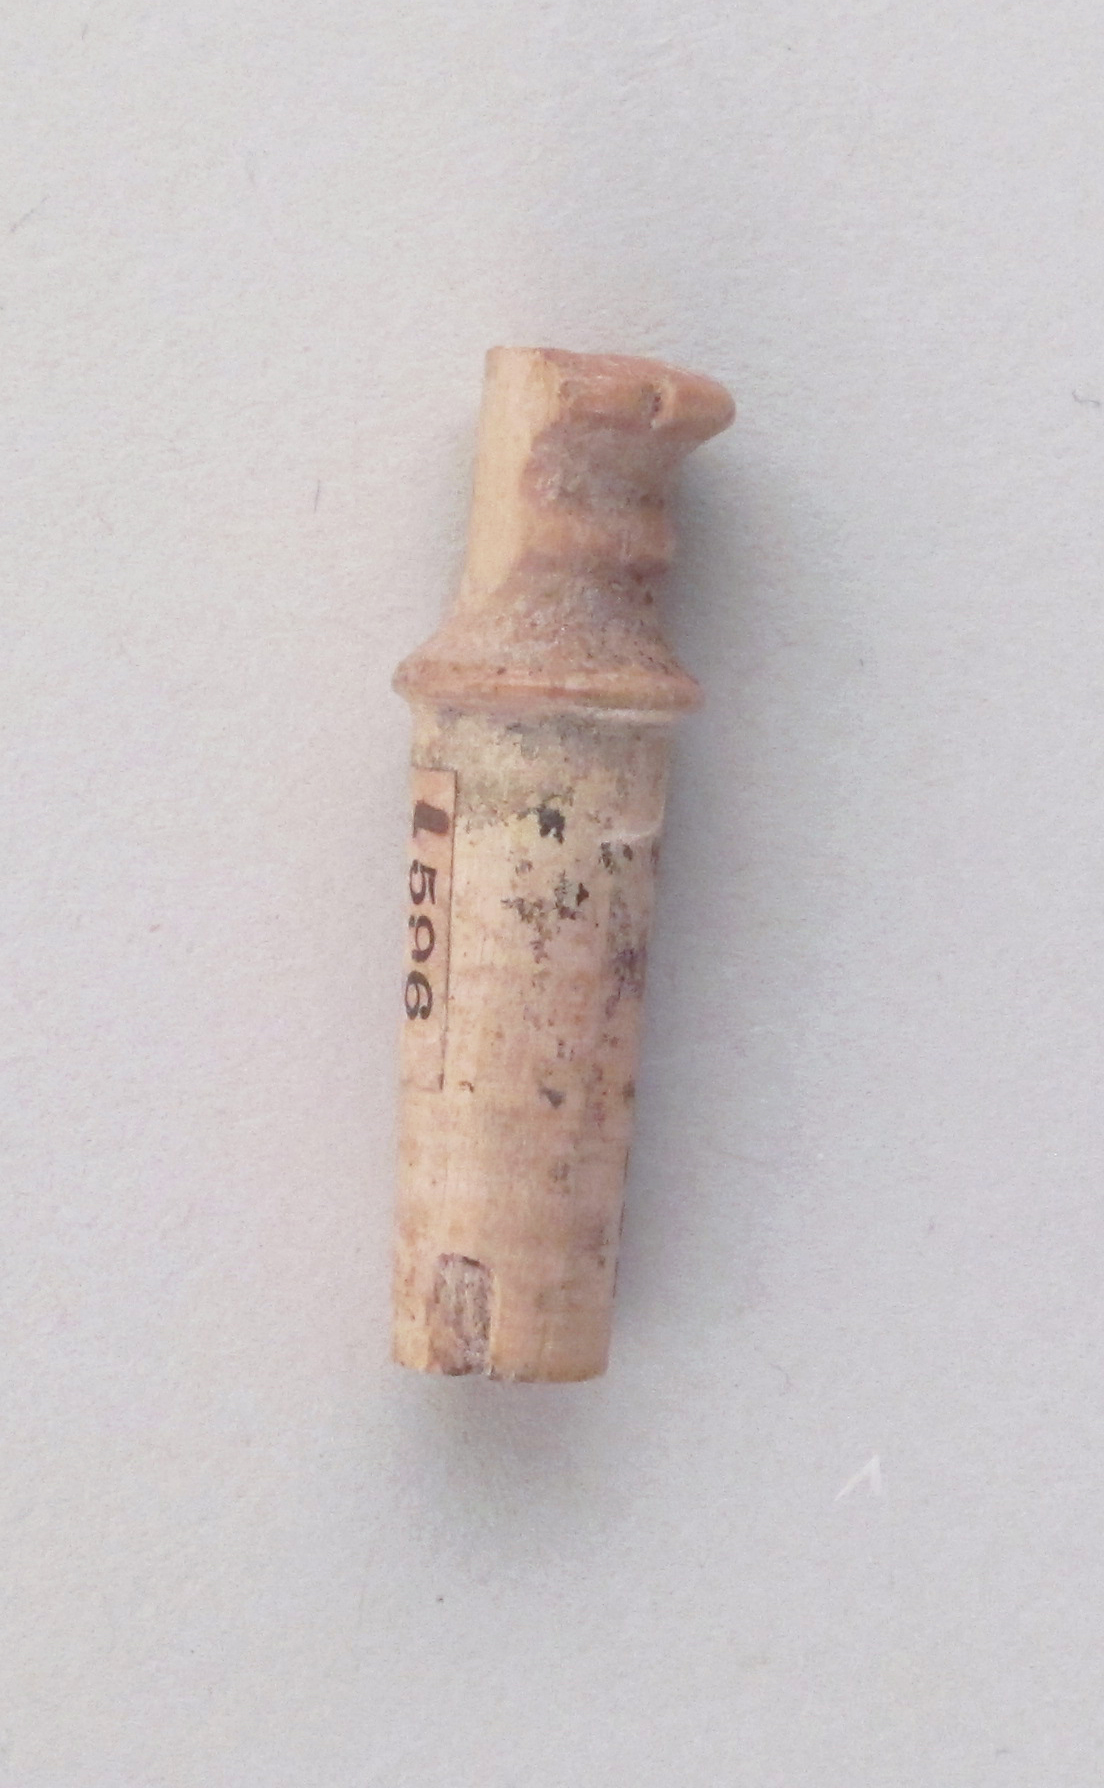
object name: pin head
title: Pin head ending in a mortice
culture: cypriot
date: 7000 BCE-330 CE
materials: bone